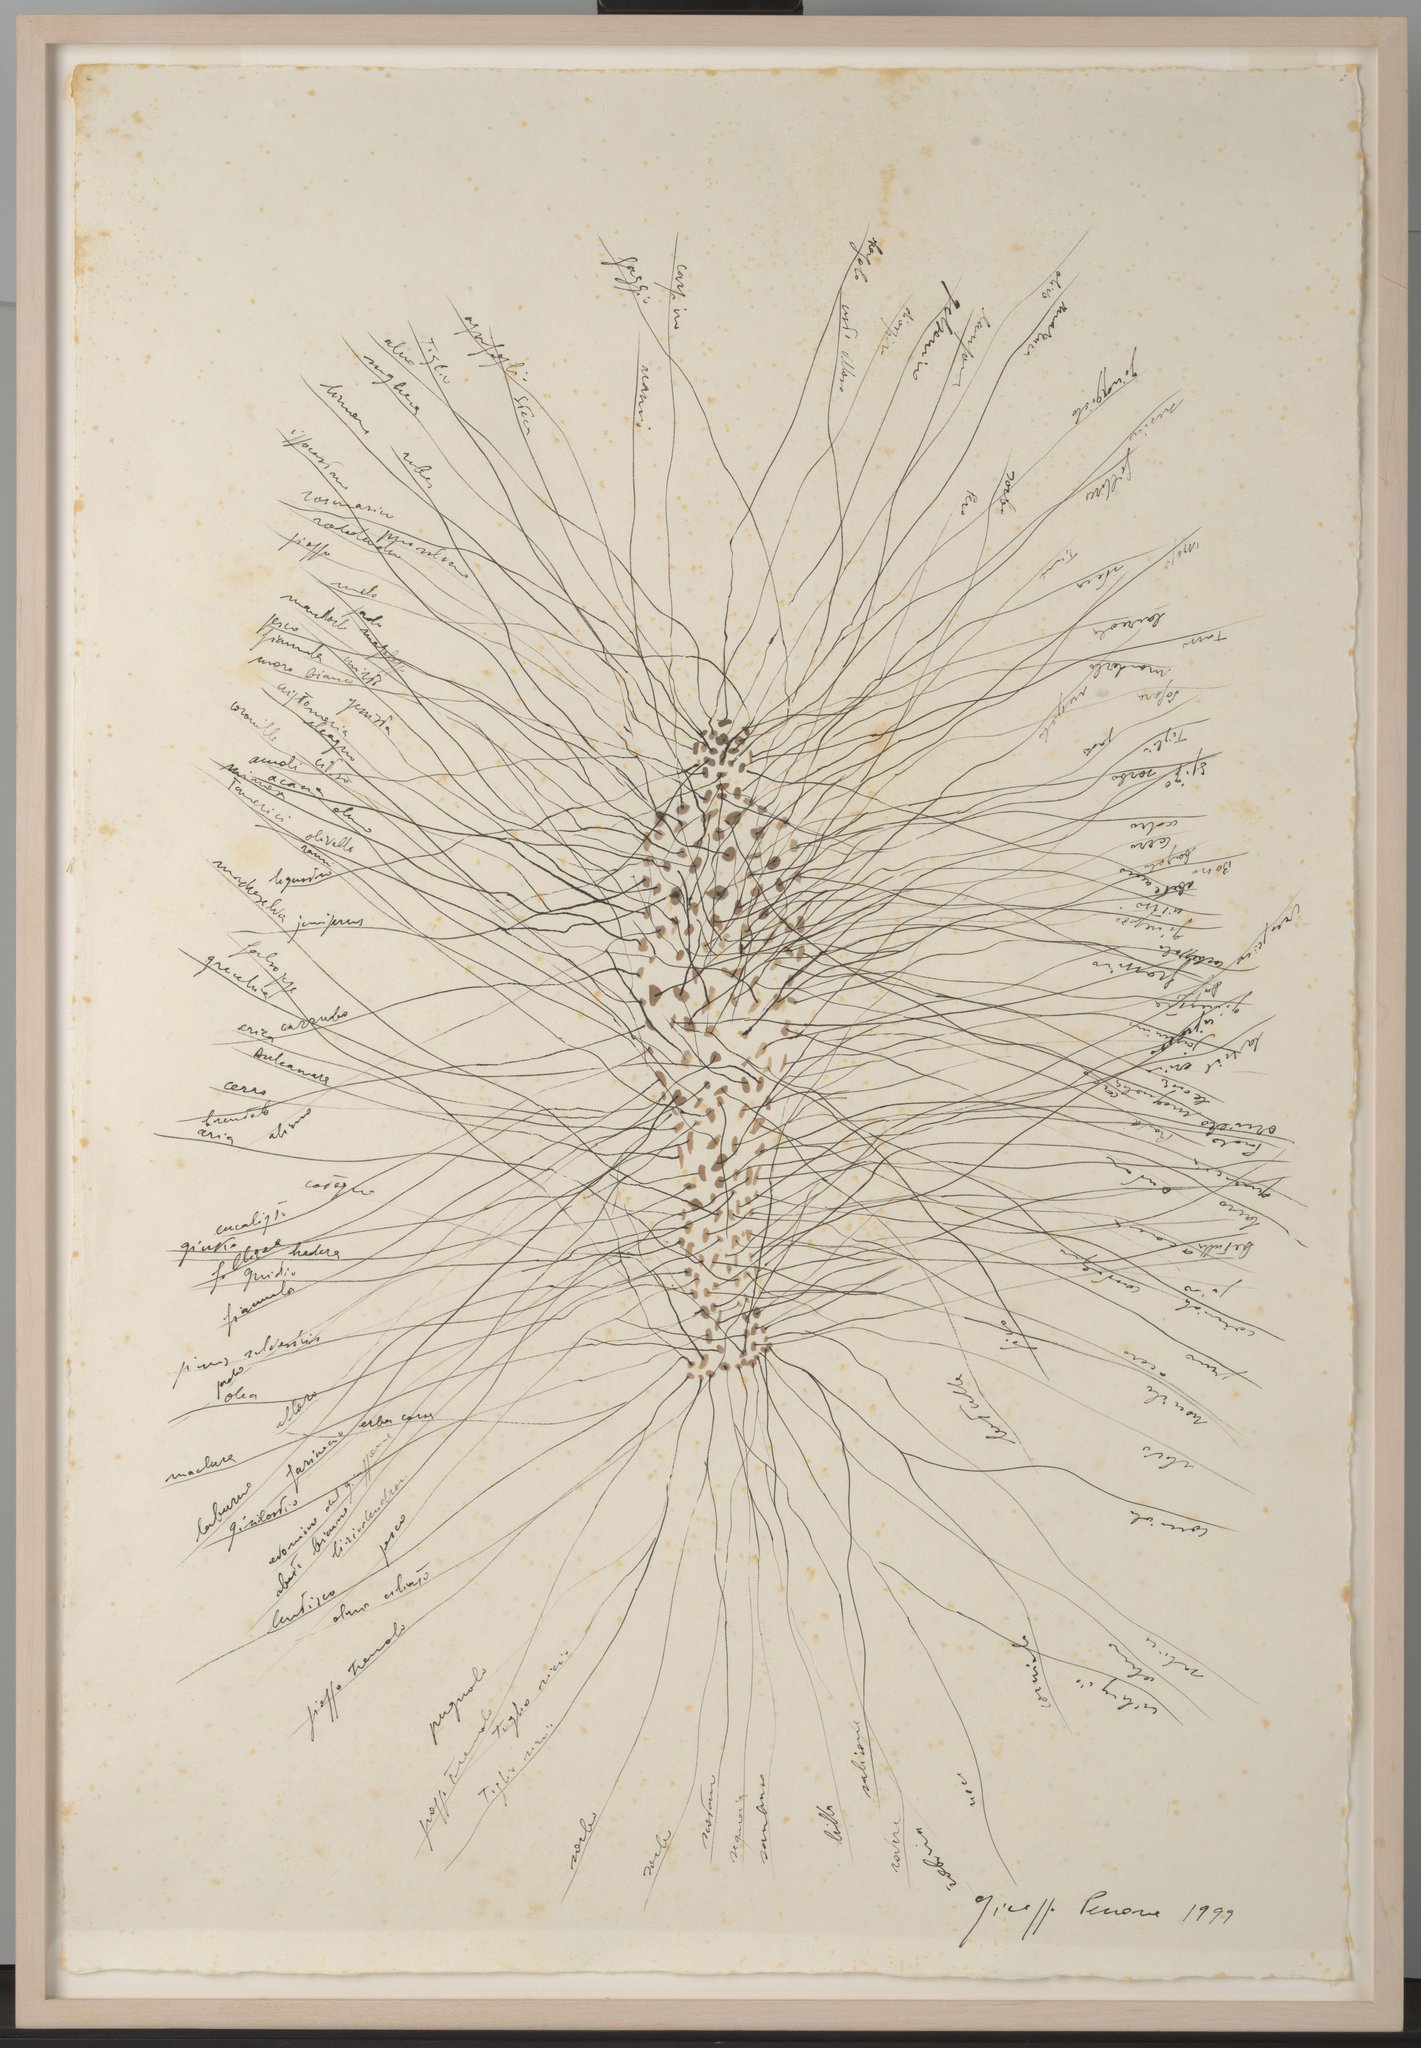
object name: frame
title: Lijst voor Penone's tekening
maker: Anonymous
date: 1400-1950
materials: glass, wood